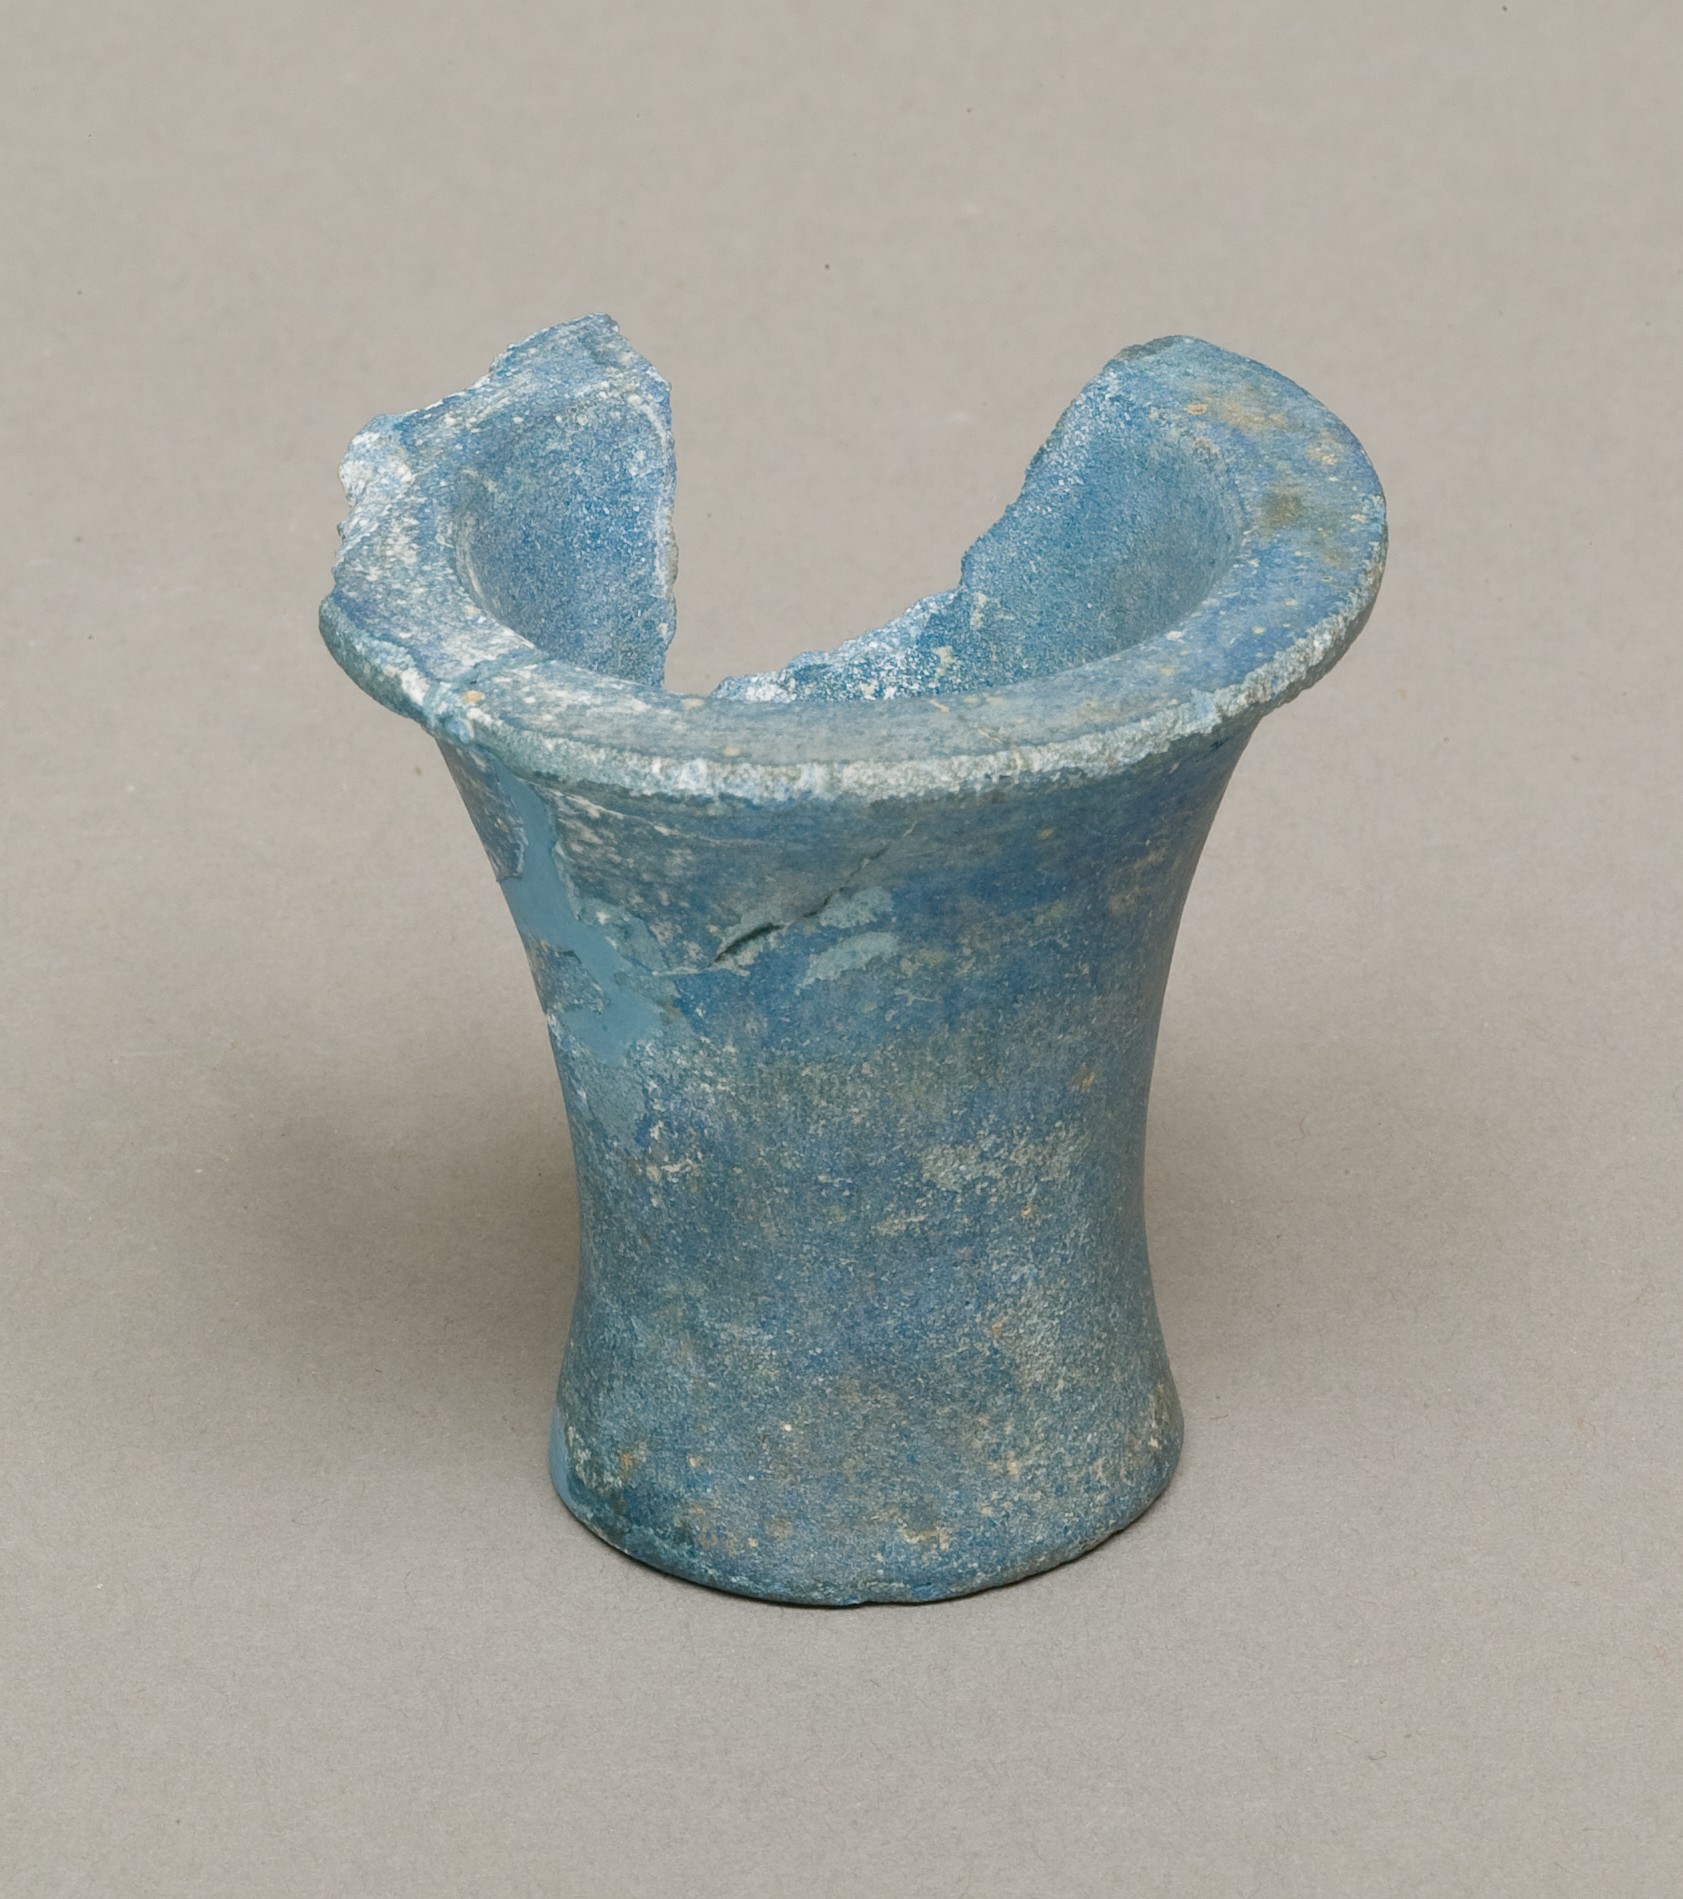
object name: cosmetic jar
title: Toilet vase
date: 1850-1700 BCE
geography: egypt